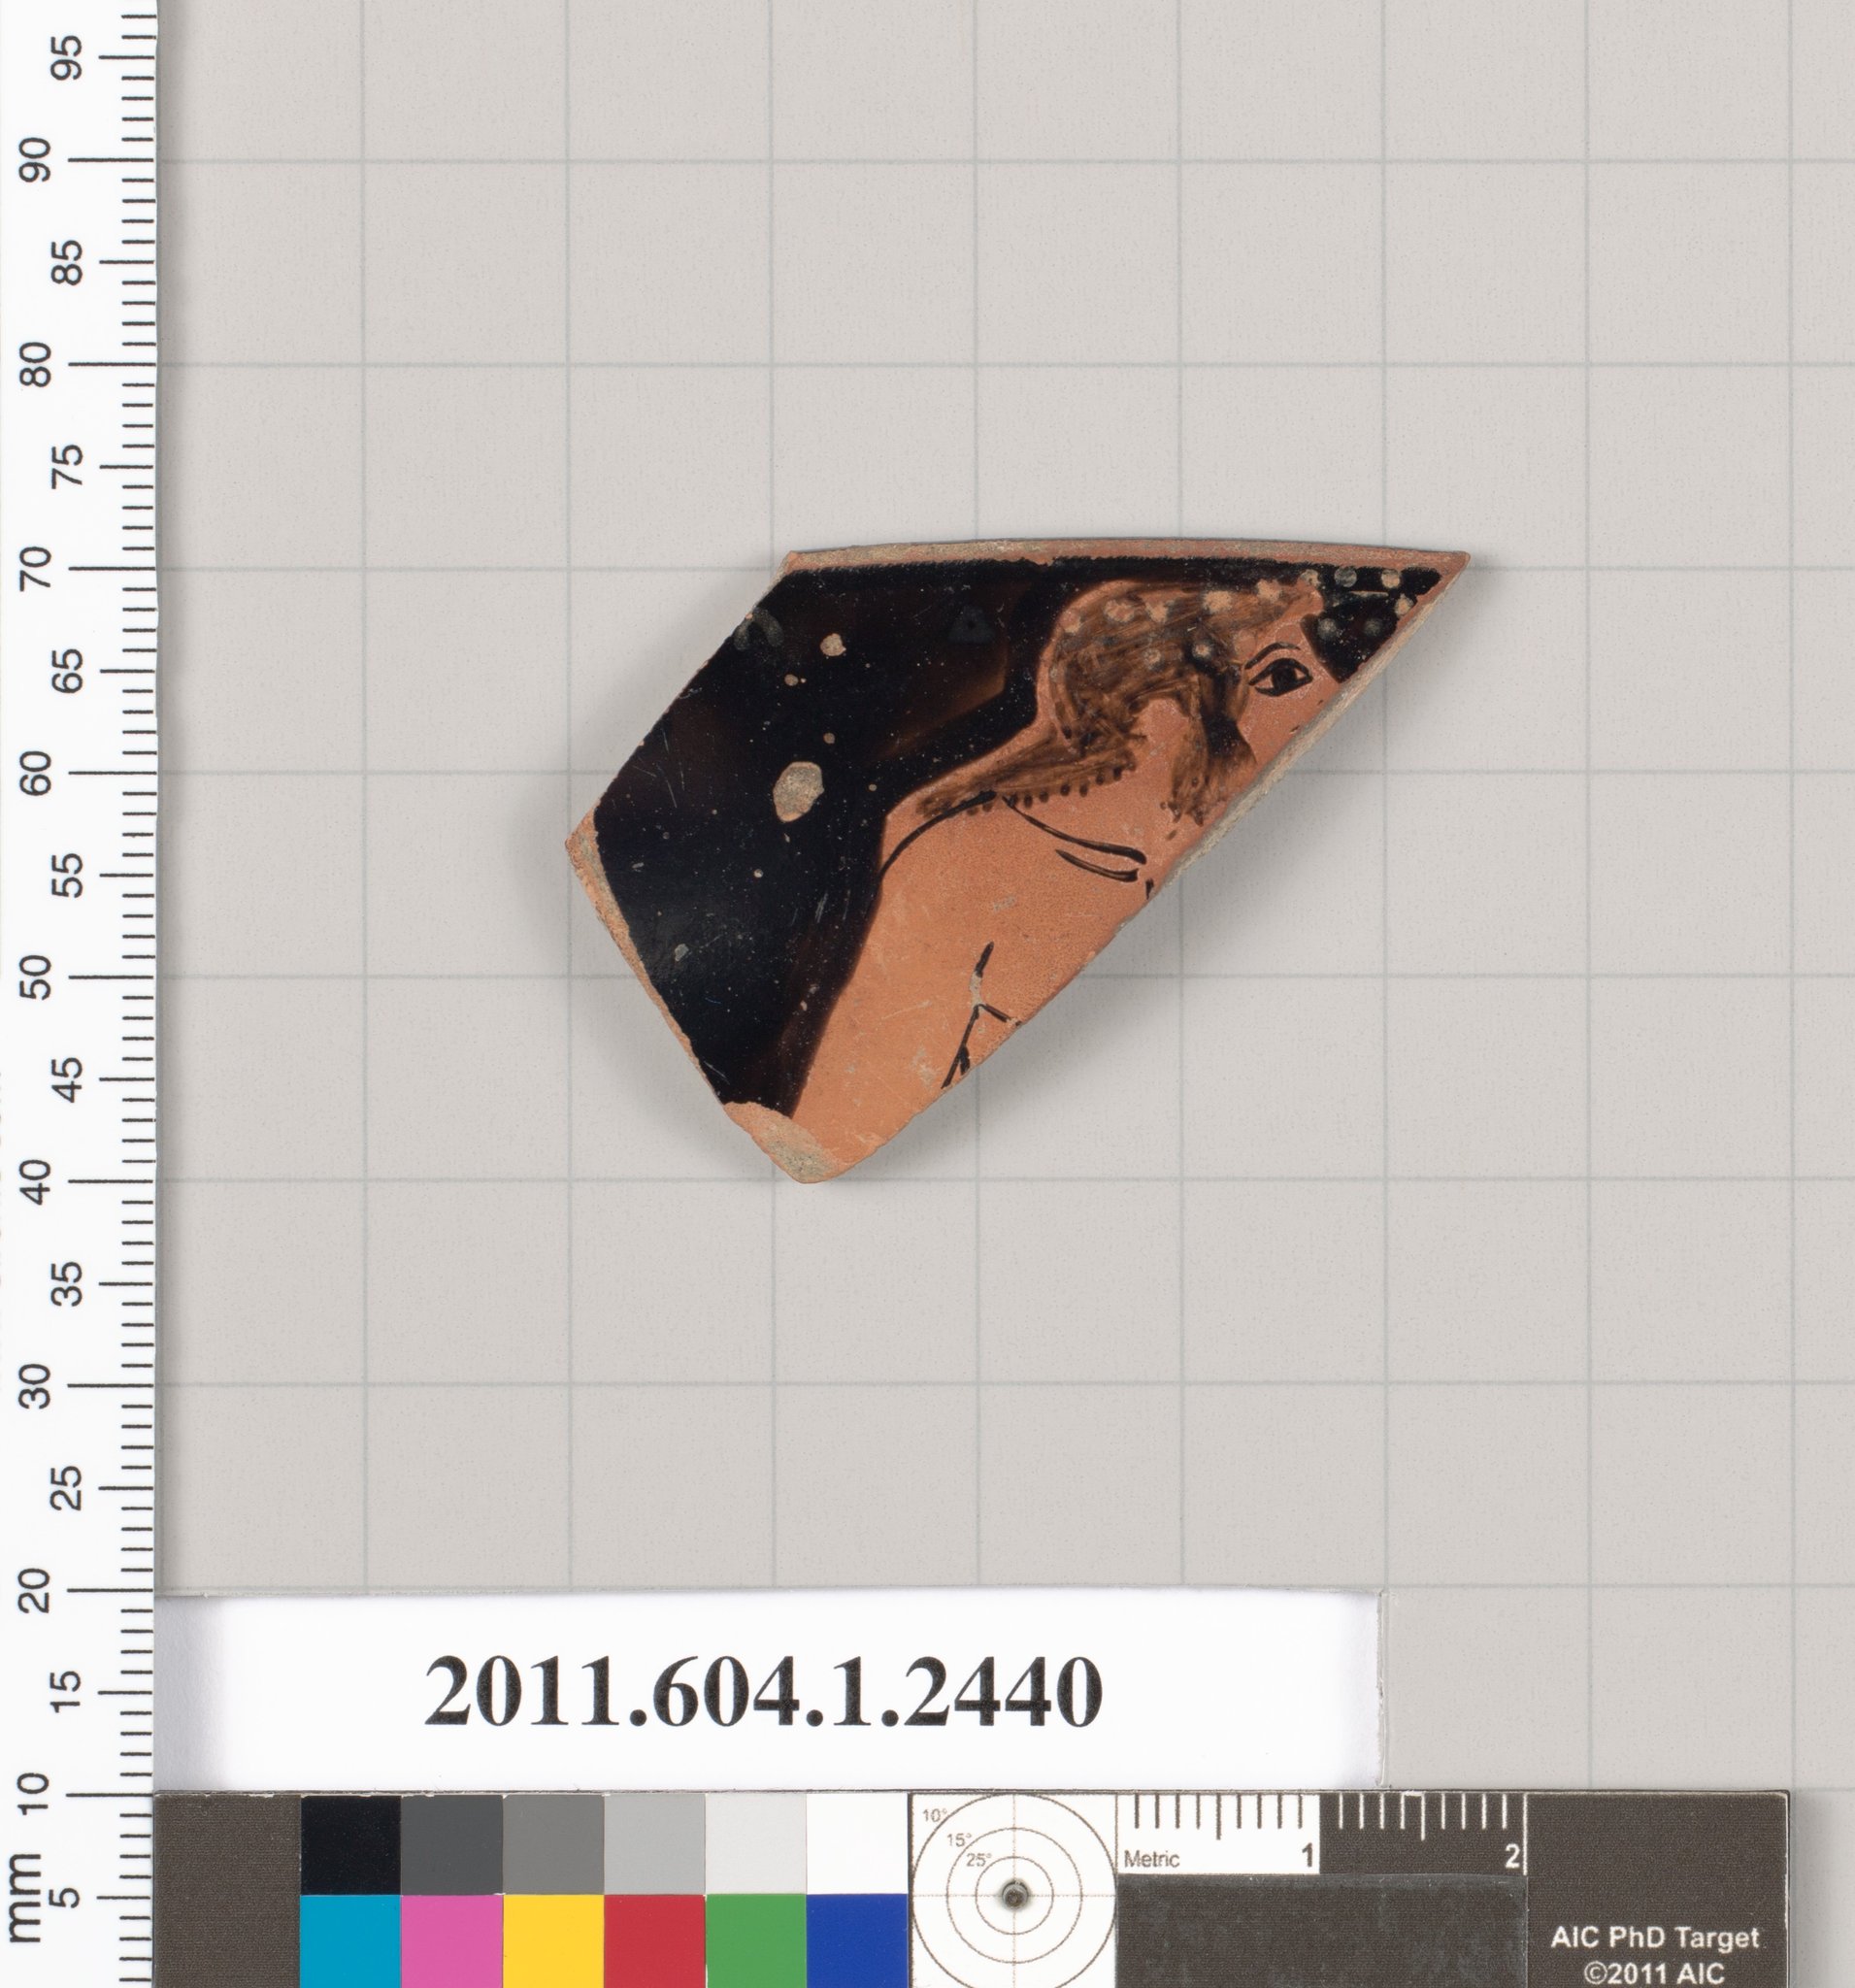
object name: kylix fragment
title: Terracotta rim fragment of a kylix (drinking cup)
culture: greek, attic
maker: ambrosios painter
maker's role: artist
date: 520-500 BCE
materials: terracotta